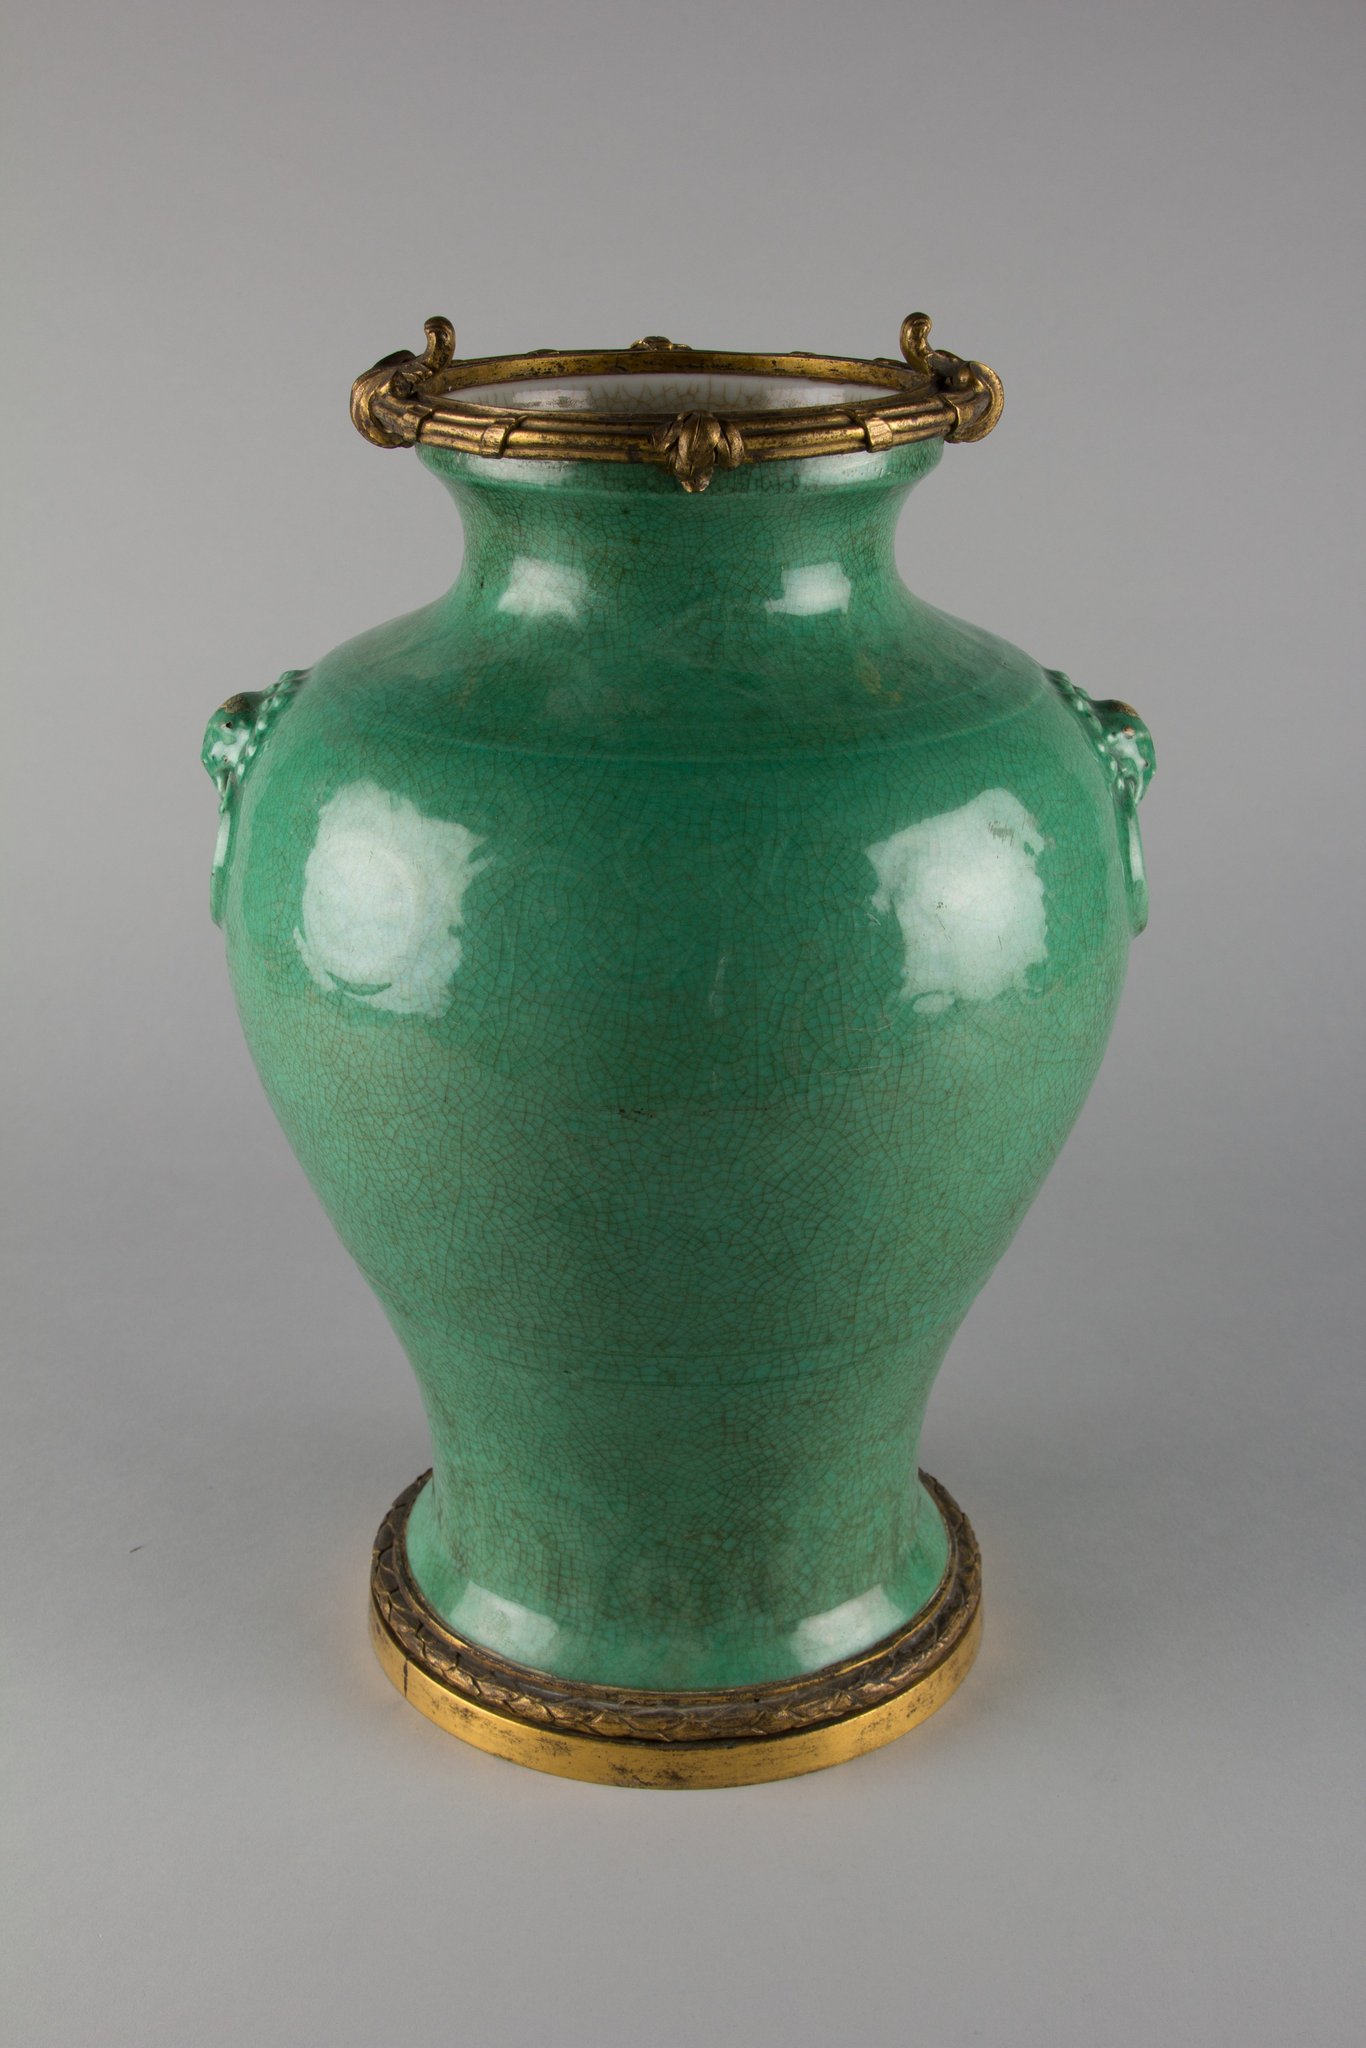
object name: jar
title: Jar with lion-head ornaments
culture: chinese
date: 1701-1800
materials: gilt bronze, glaze, porcelain